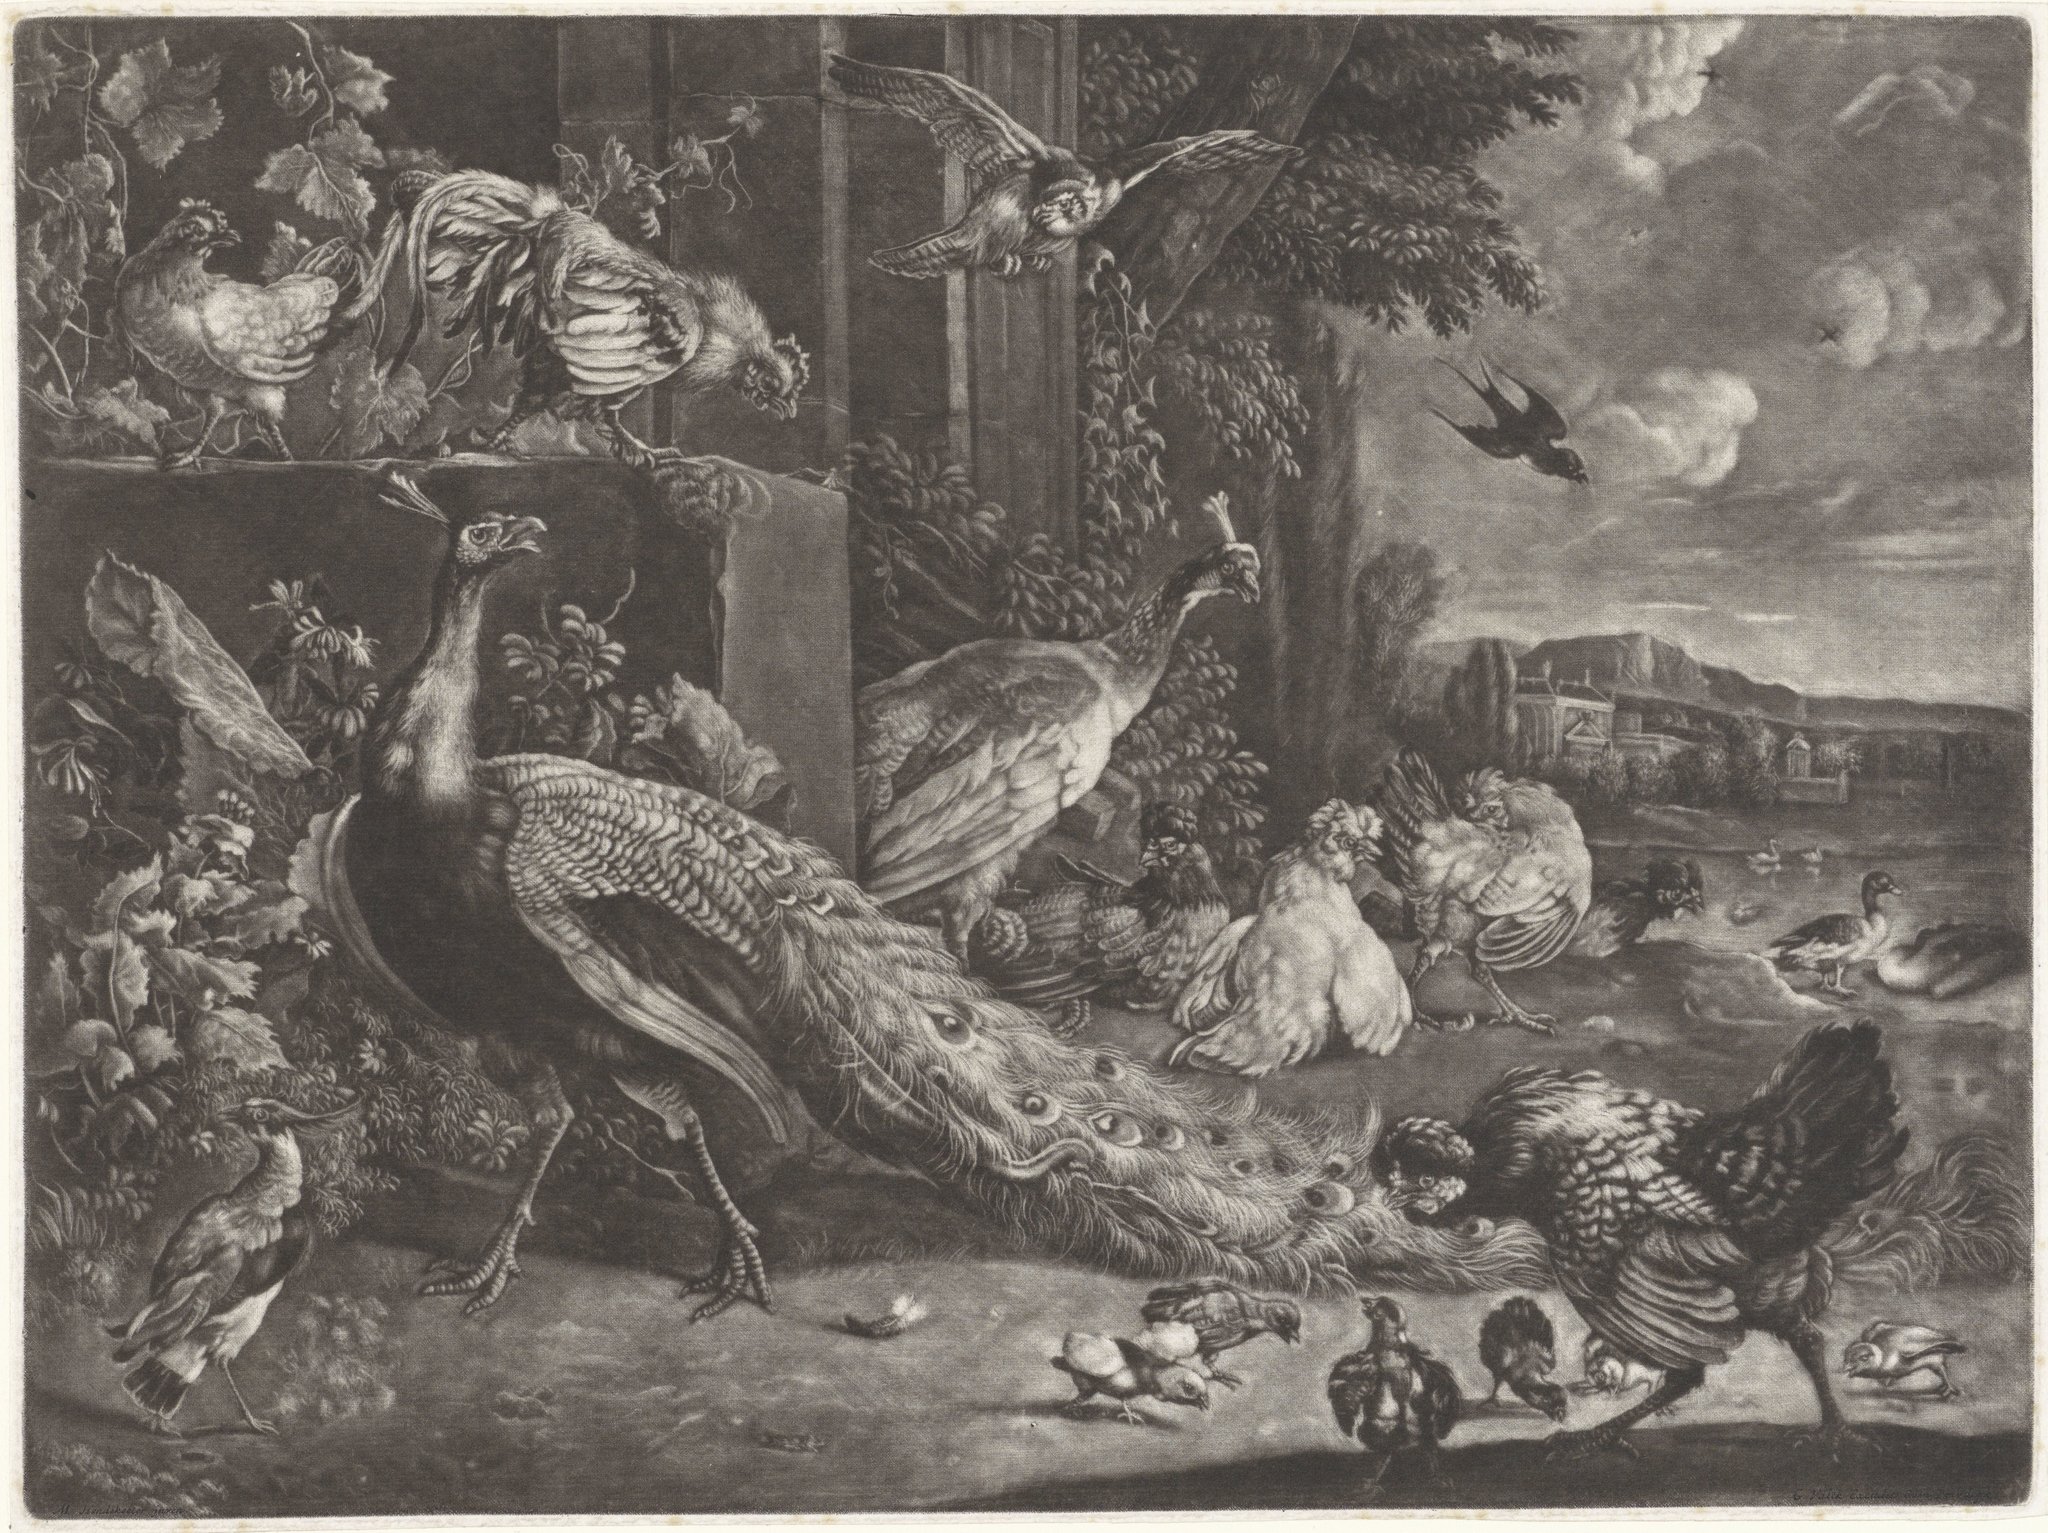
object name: print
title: Landschap met gevogelte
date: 1662-1726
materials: paper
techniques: mezzotint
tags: landscapes, ornamental birds: peacock, fowl (cock, hen, chicken, etc.), water-birds: duck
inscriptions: collector's mark: Lugt 240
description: Landschap met divers gevogelte, waaronder een pauw en een hen met kuikens. Op de achtergrond een landhuis.